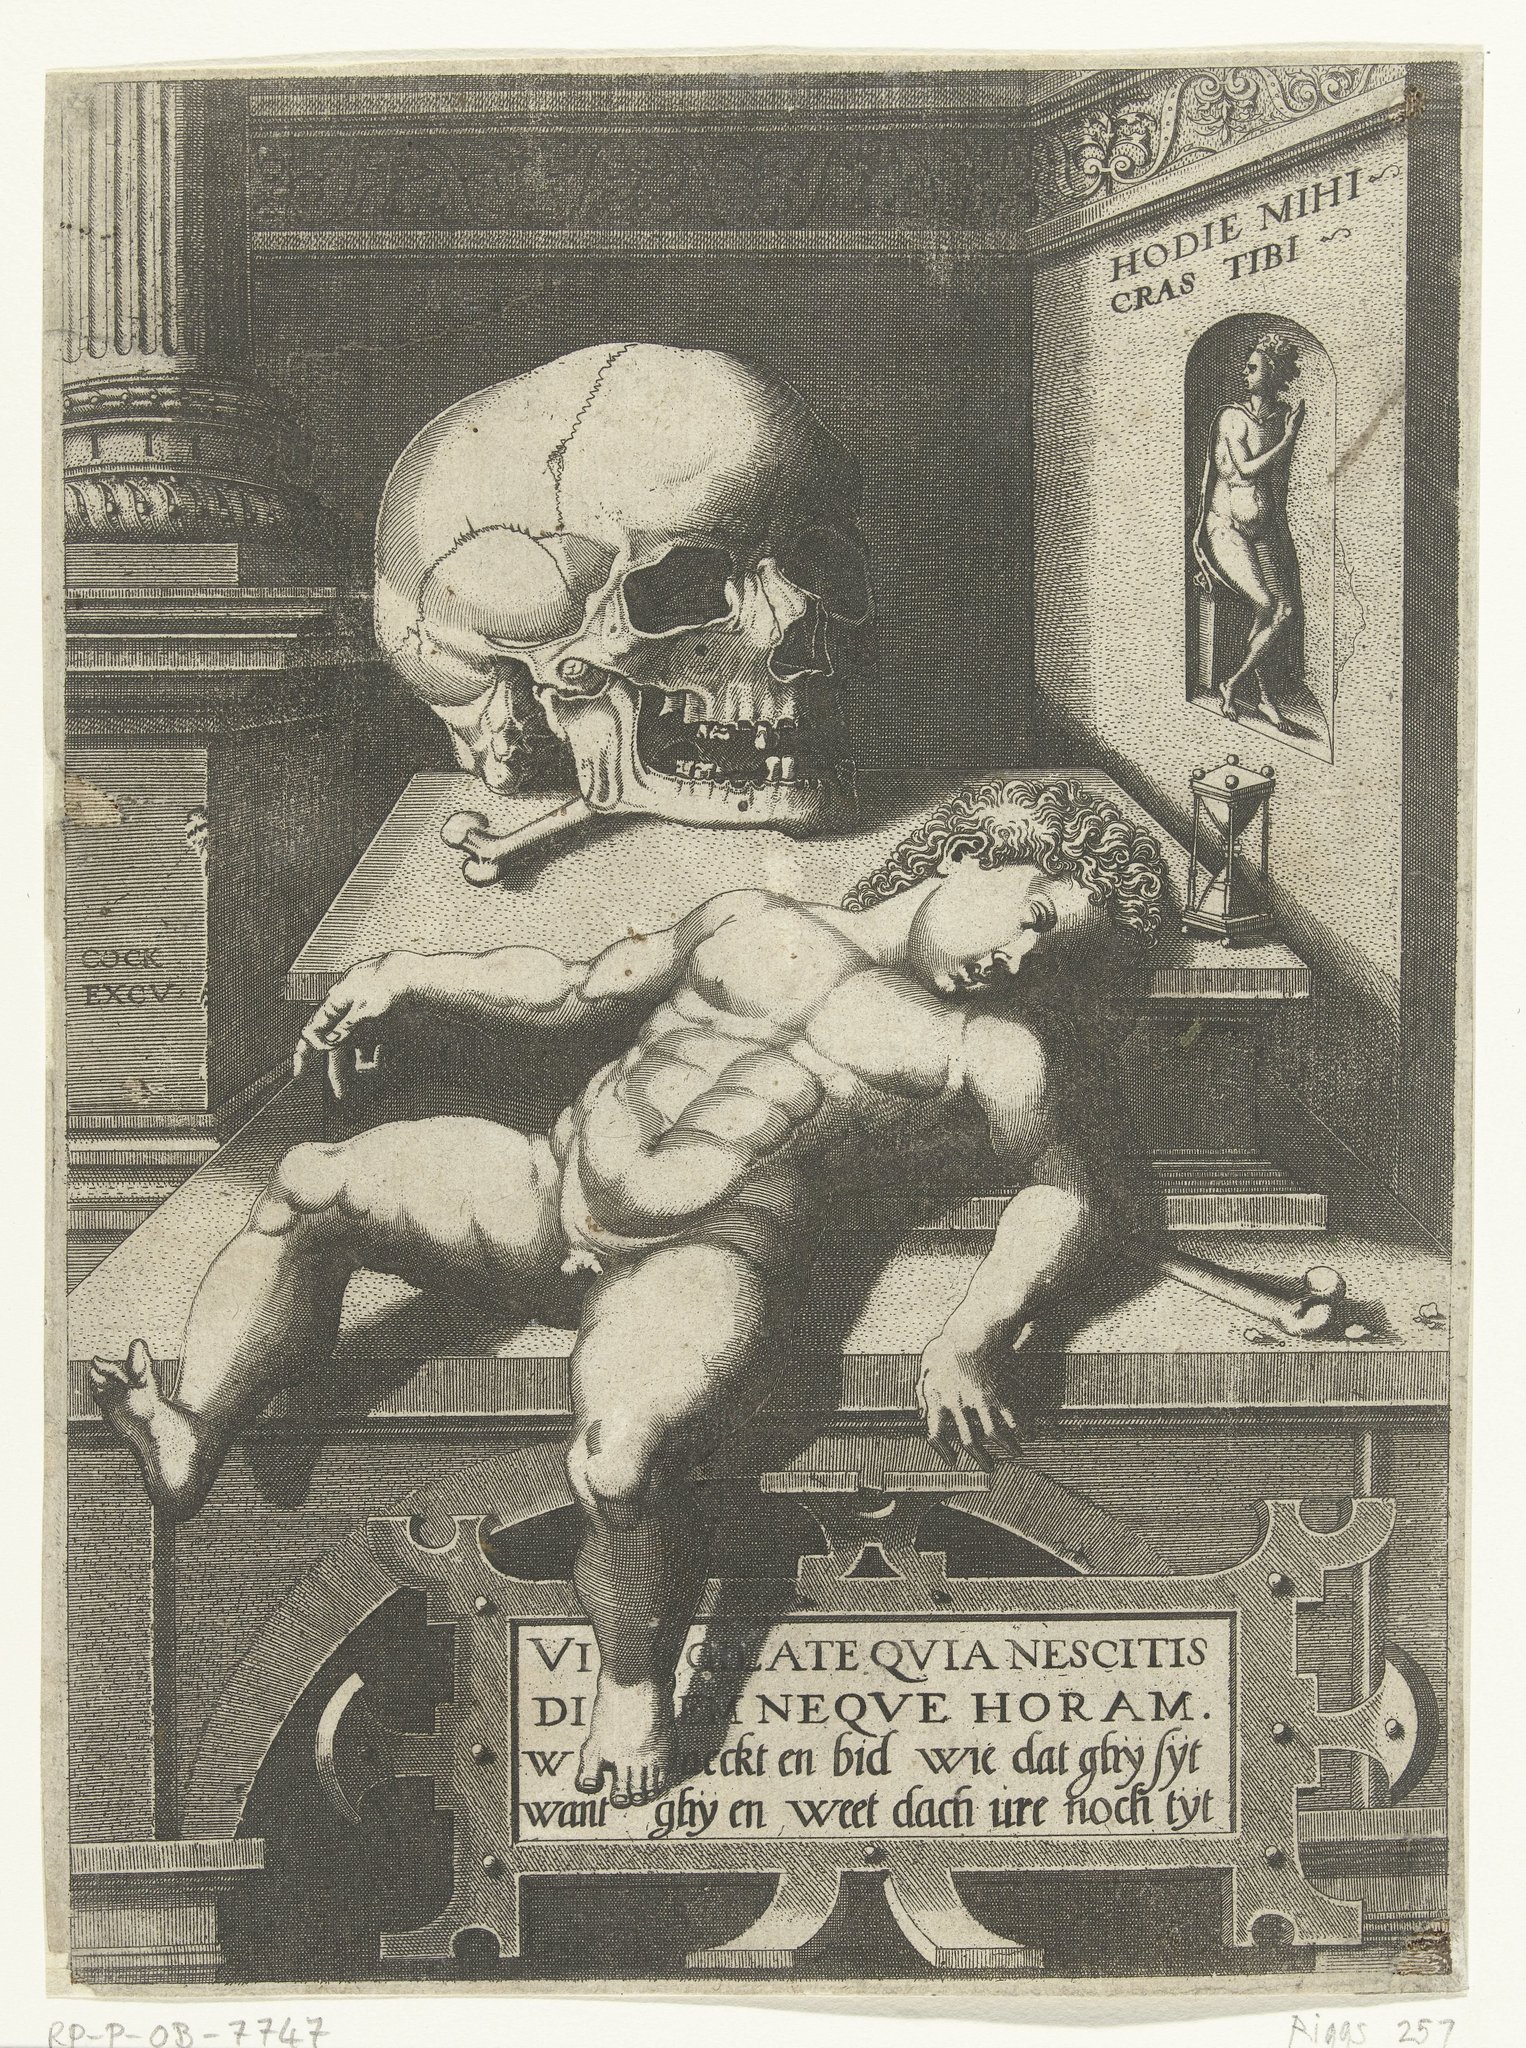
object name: print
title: Vanitasvoorstelling met kind en schedel (Hodi mihi kras tibi / Heden ik, morgen gij)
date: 1550-1570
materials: paper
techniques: engraving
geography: antwerp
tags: 'vanitas' symbols, grave, tomb, skull as symbol of 'vanitas'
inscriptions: collector's mark: Lugt 2228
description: Vanitasvoorstelling, op een stenen tombe liggen een schedel en botten en een naakt jongetje. Naast zijn hoofd staat een zandloper. Aan de muur en op de tombe bevinden zich cartouches met verwijzingen naar vergankelijkheid in het Nederlands en het Latijn.